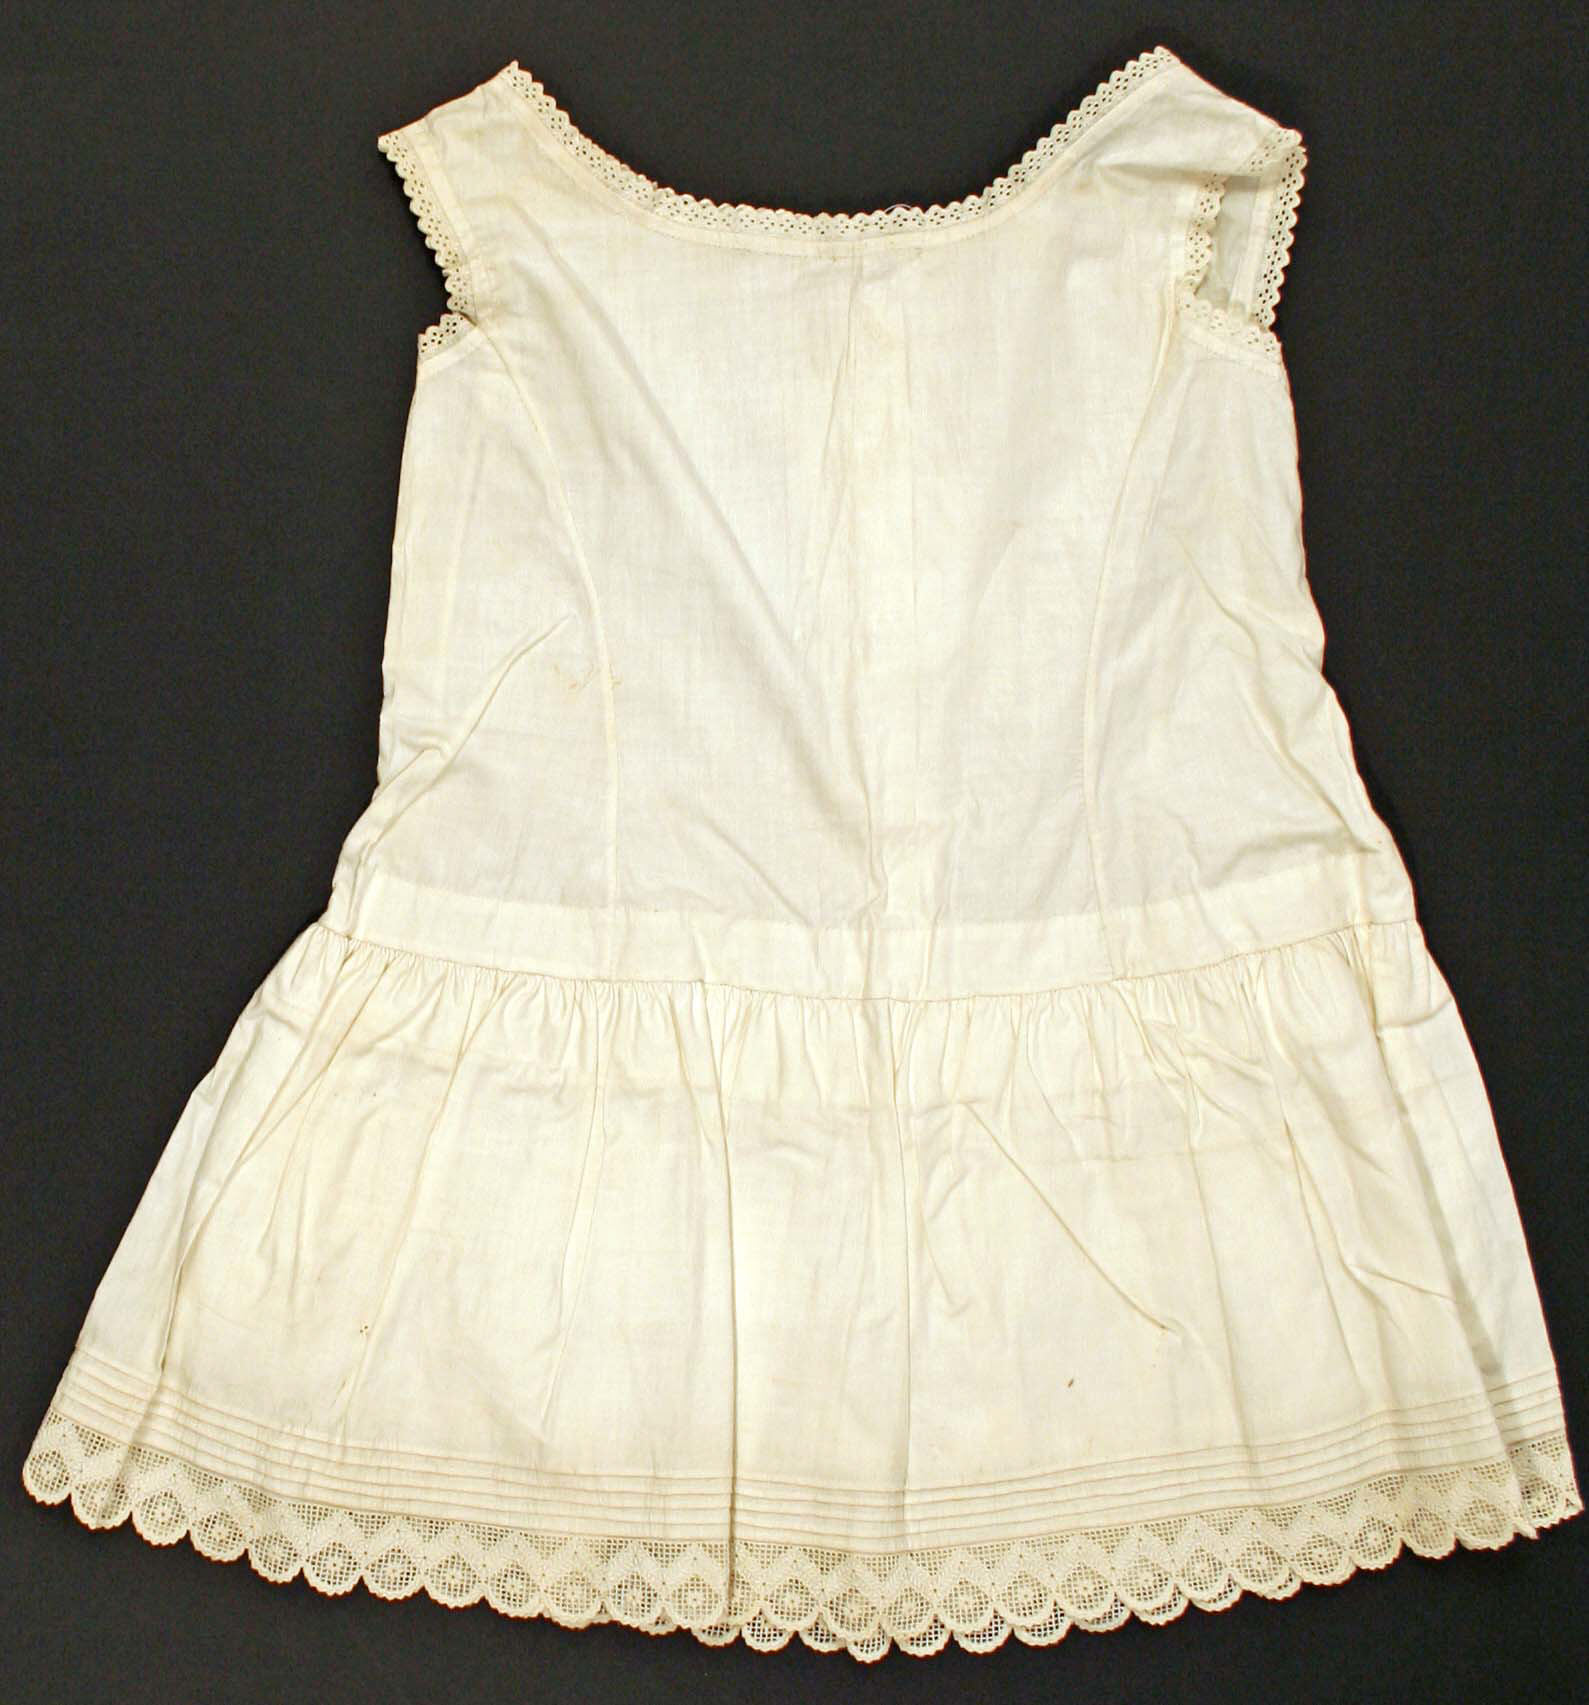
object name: underskirt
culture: american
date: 1860-1865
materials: cotton